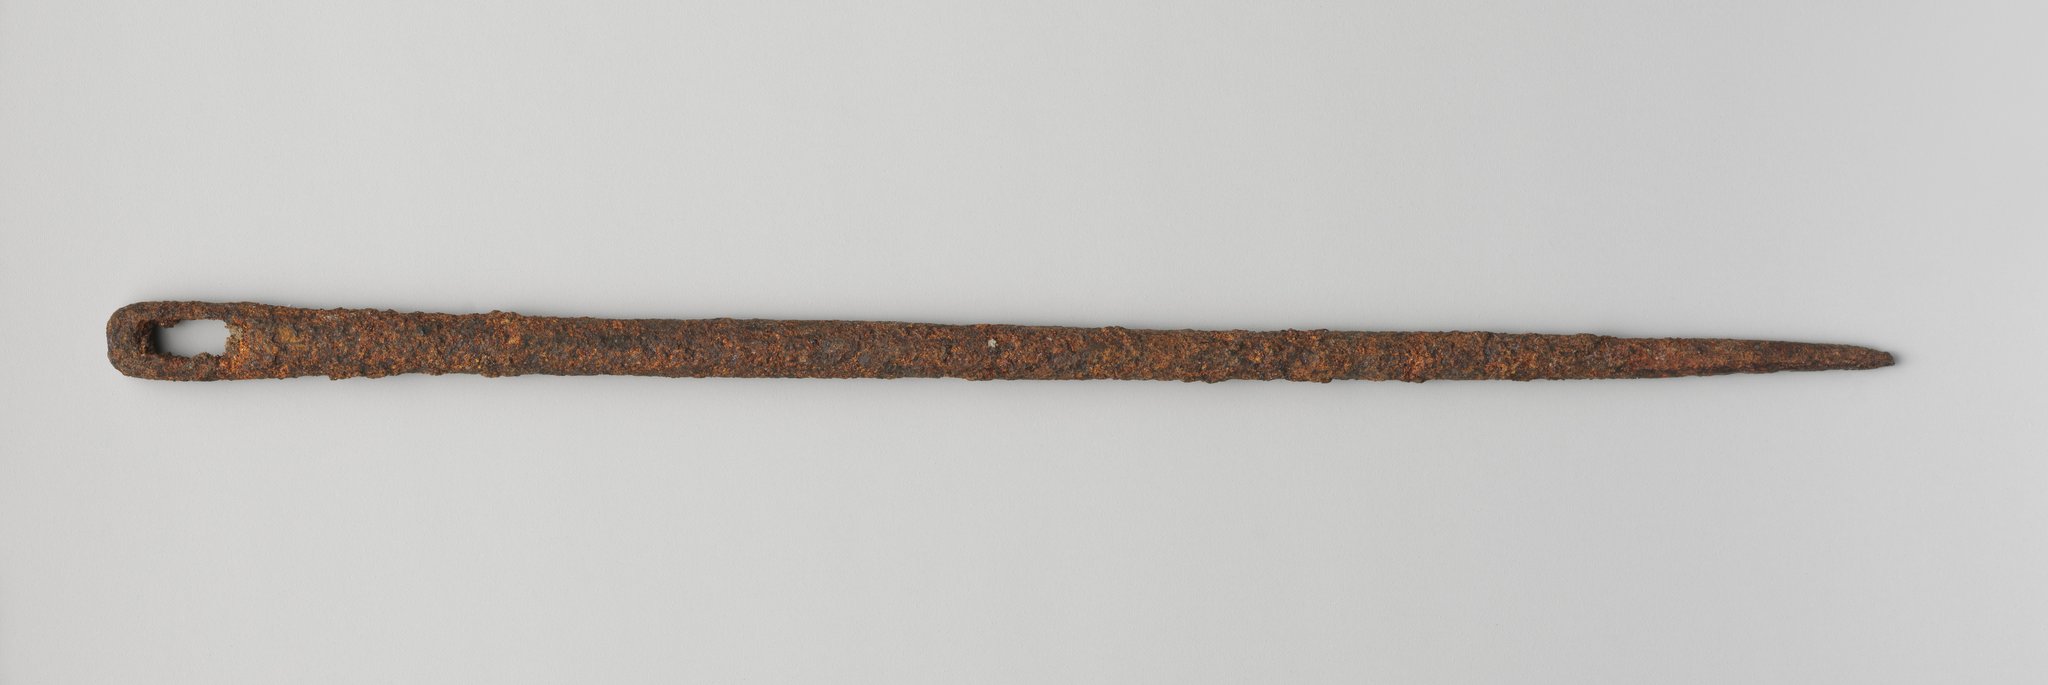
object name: needle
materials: bronze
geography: egypt